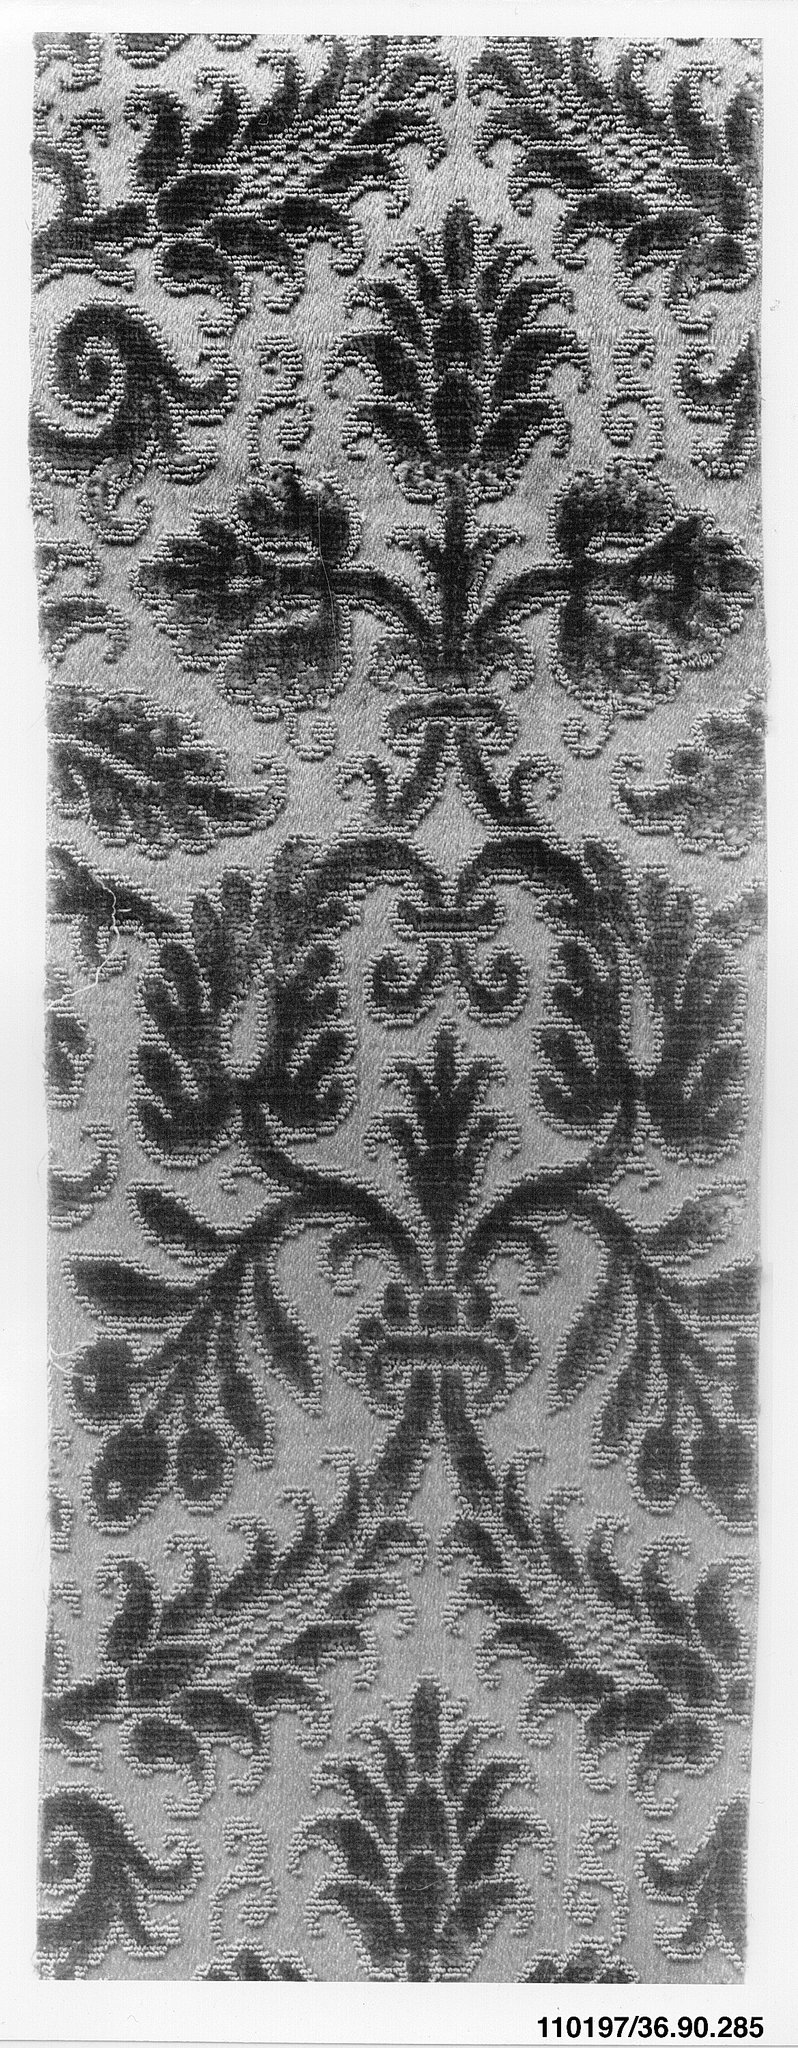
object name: piece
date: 1501-1700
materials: silk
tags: leaves